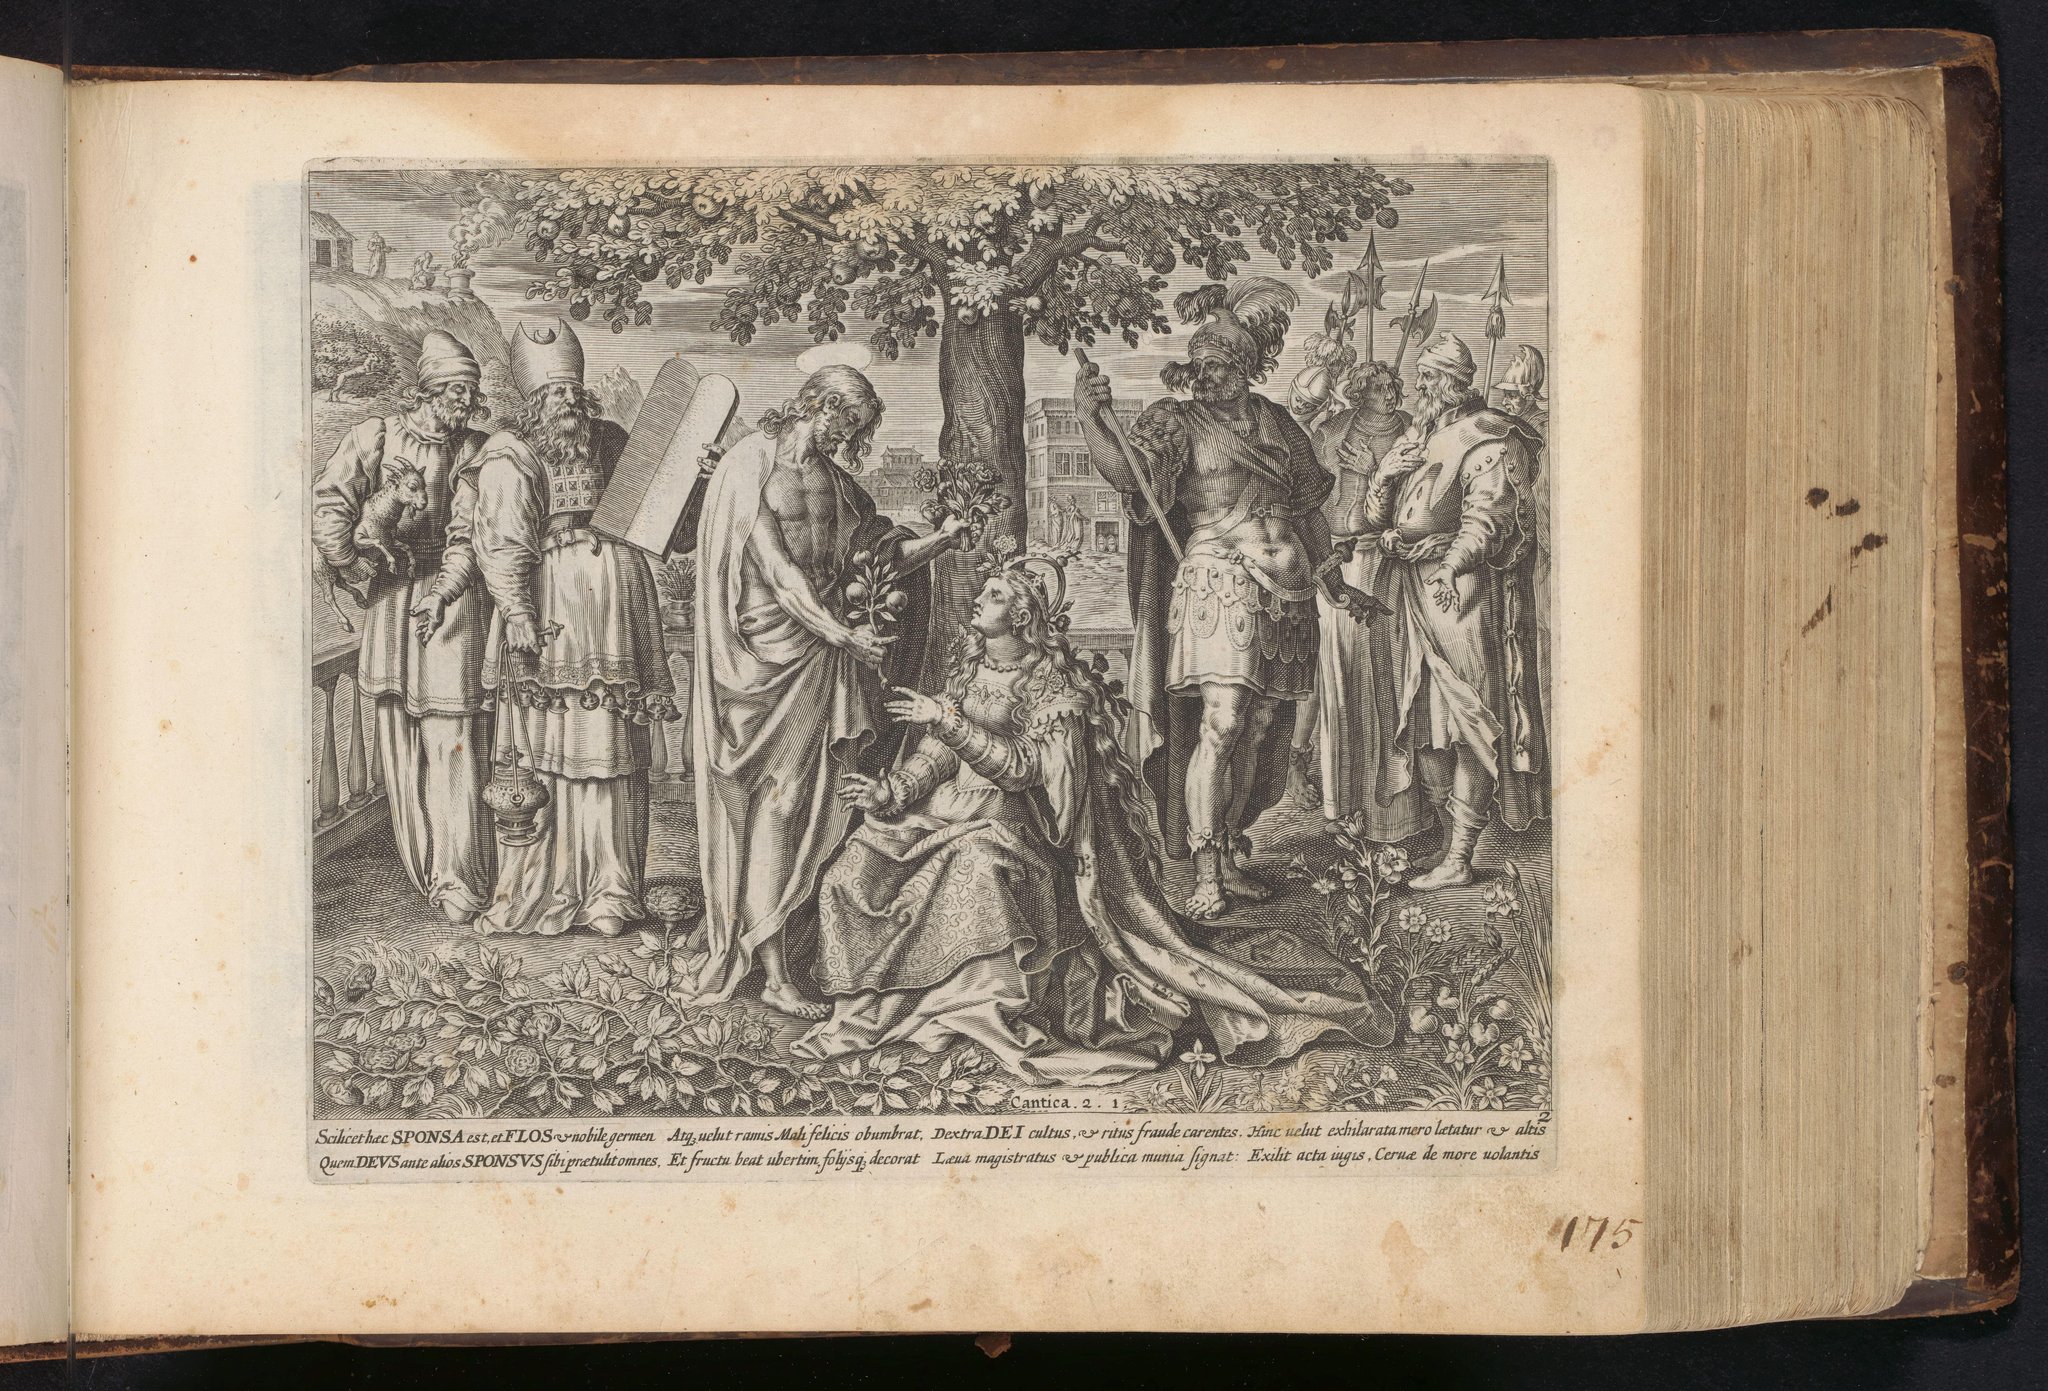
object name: album leaf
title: Van den Cantica Canticorum Salomons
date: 1643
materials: paper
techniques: engraving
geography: alkmaar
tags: 'ecclesia' as bride of christ (the lamb), 'ecclesia sponsa dei', 'sponsus-sponsa', song of solomon, song of songs (with book chapter:verse) (+ christ bearded), garden, groups of persons from the old testament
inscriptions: number: ‘175’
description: De bruid van Christus (de kerk) zit onder een appelboom in een bloementuin en ontvangt bloemen van Christus die naast haar staat. Links en rechts personen uit het Oude Testament. Onder de voorstelling een verwijzing in het Latijn naar de Bijbeltekst in Hoogl. 2:1. Deze prent maakt deel uit van een album.